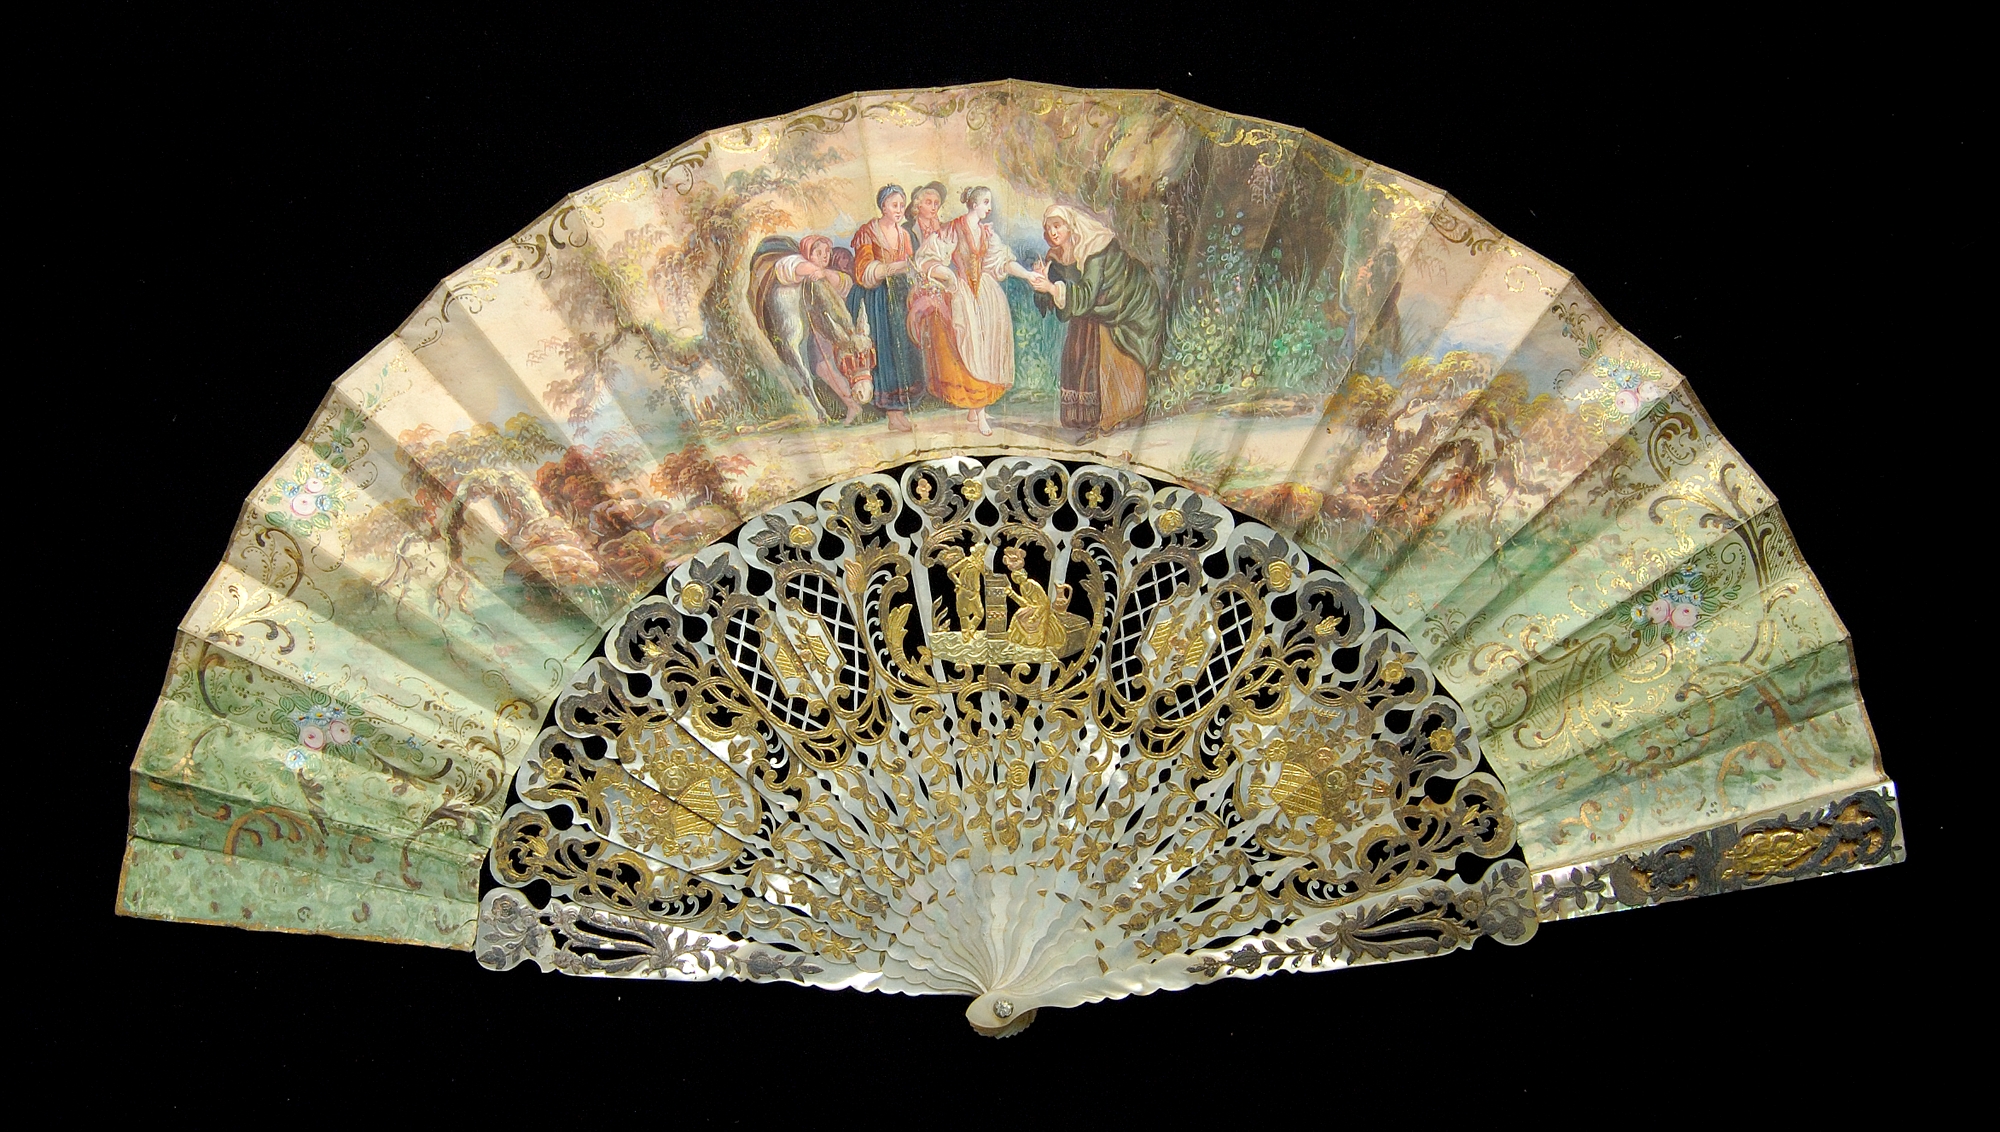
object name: fan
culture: european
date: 1851-1875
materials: mother of pearl, paper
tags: women,donkeys